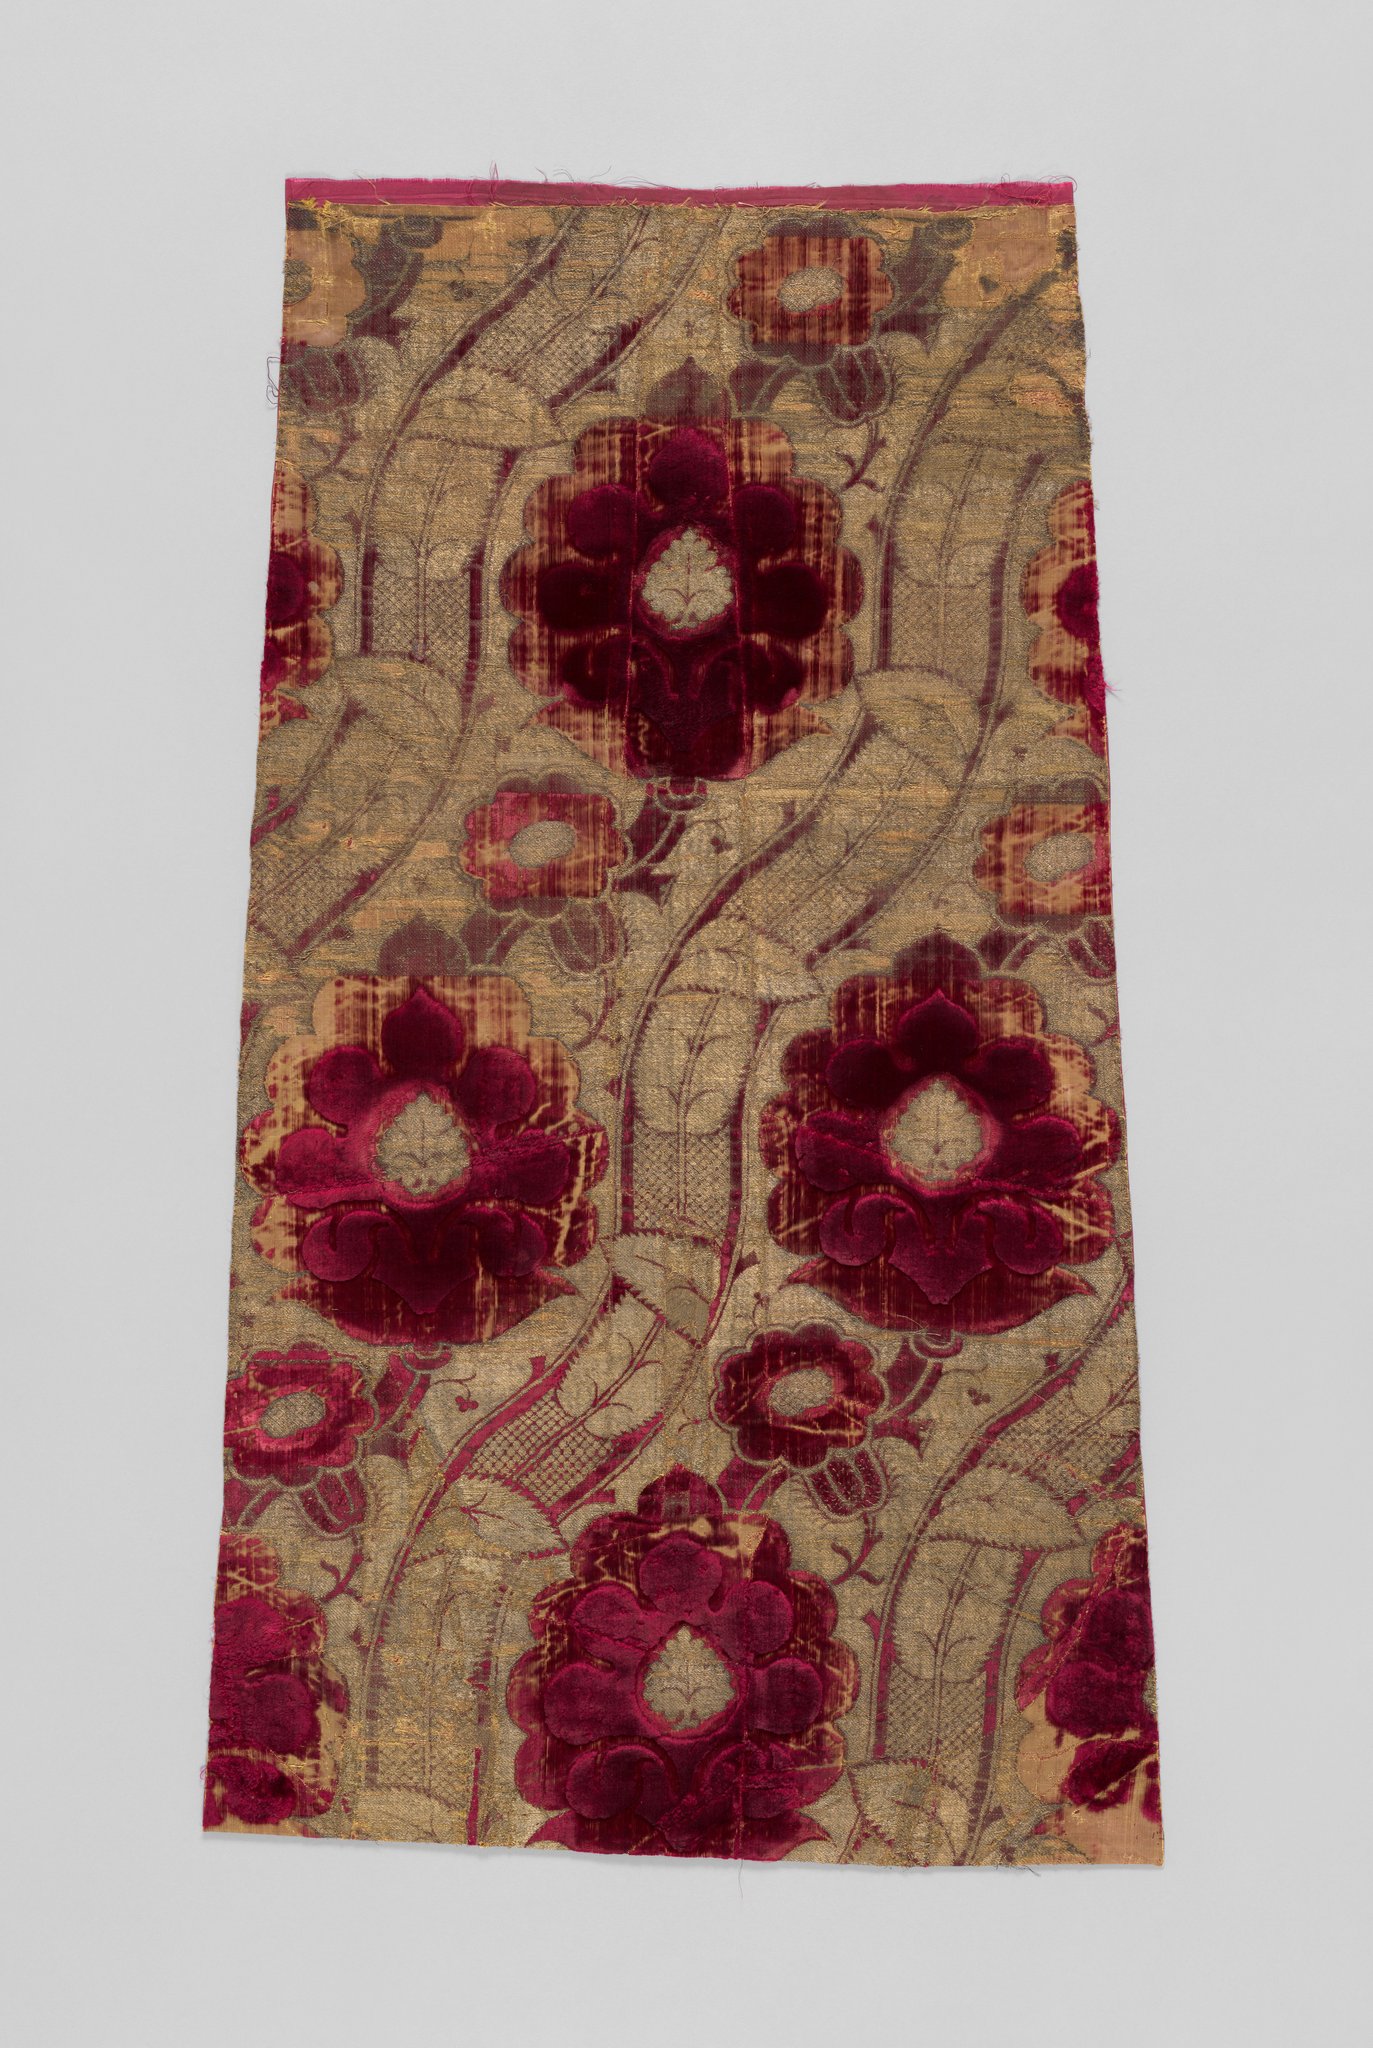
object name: piece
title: Pieces (4)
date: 1401-1500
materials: metal thread, silk